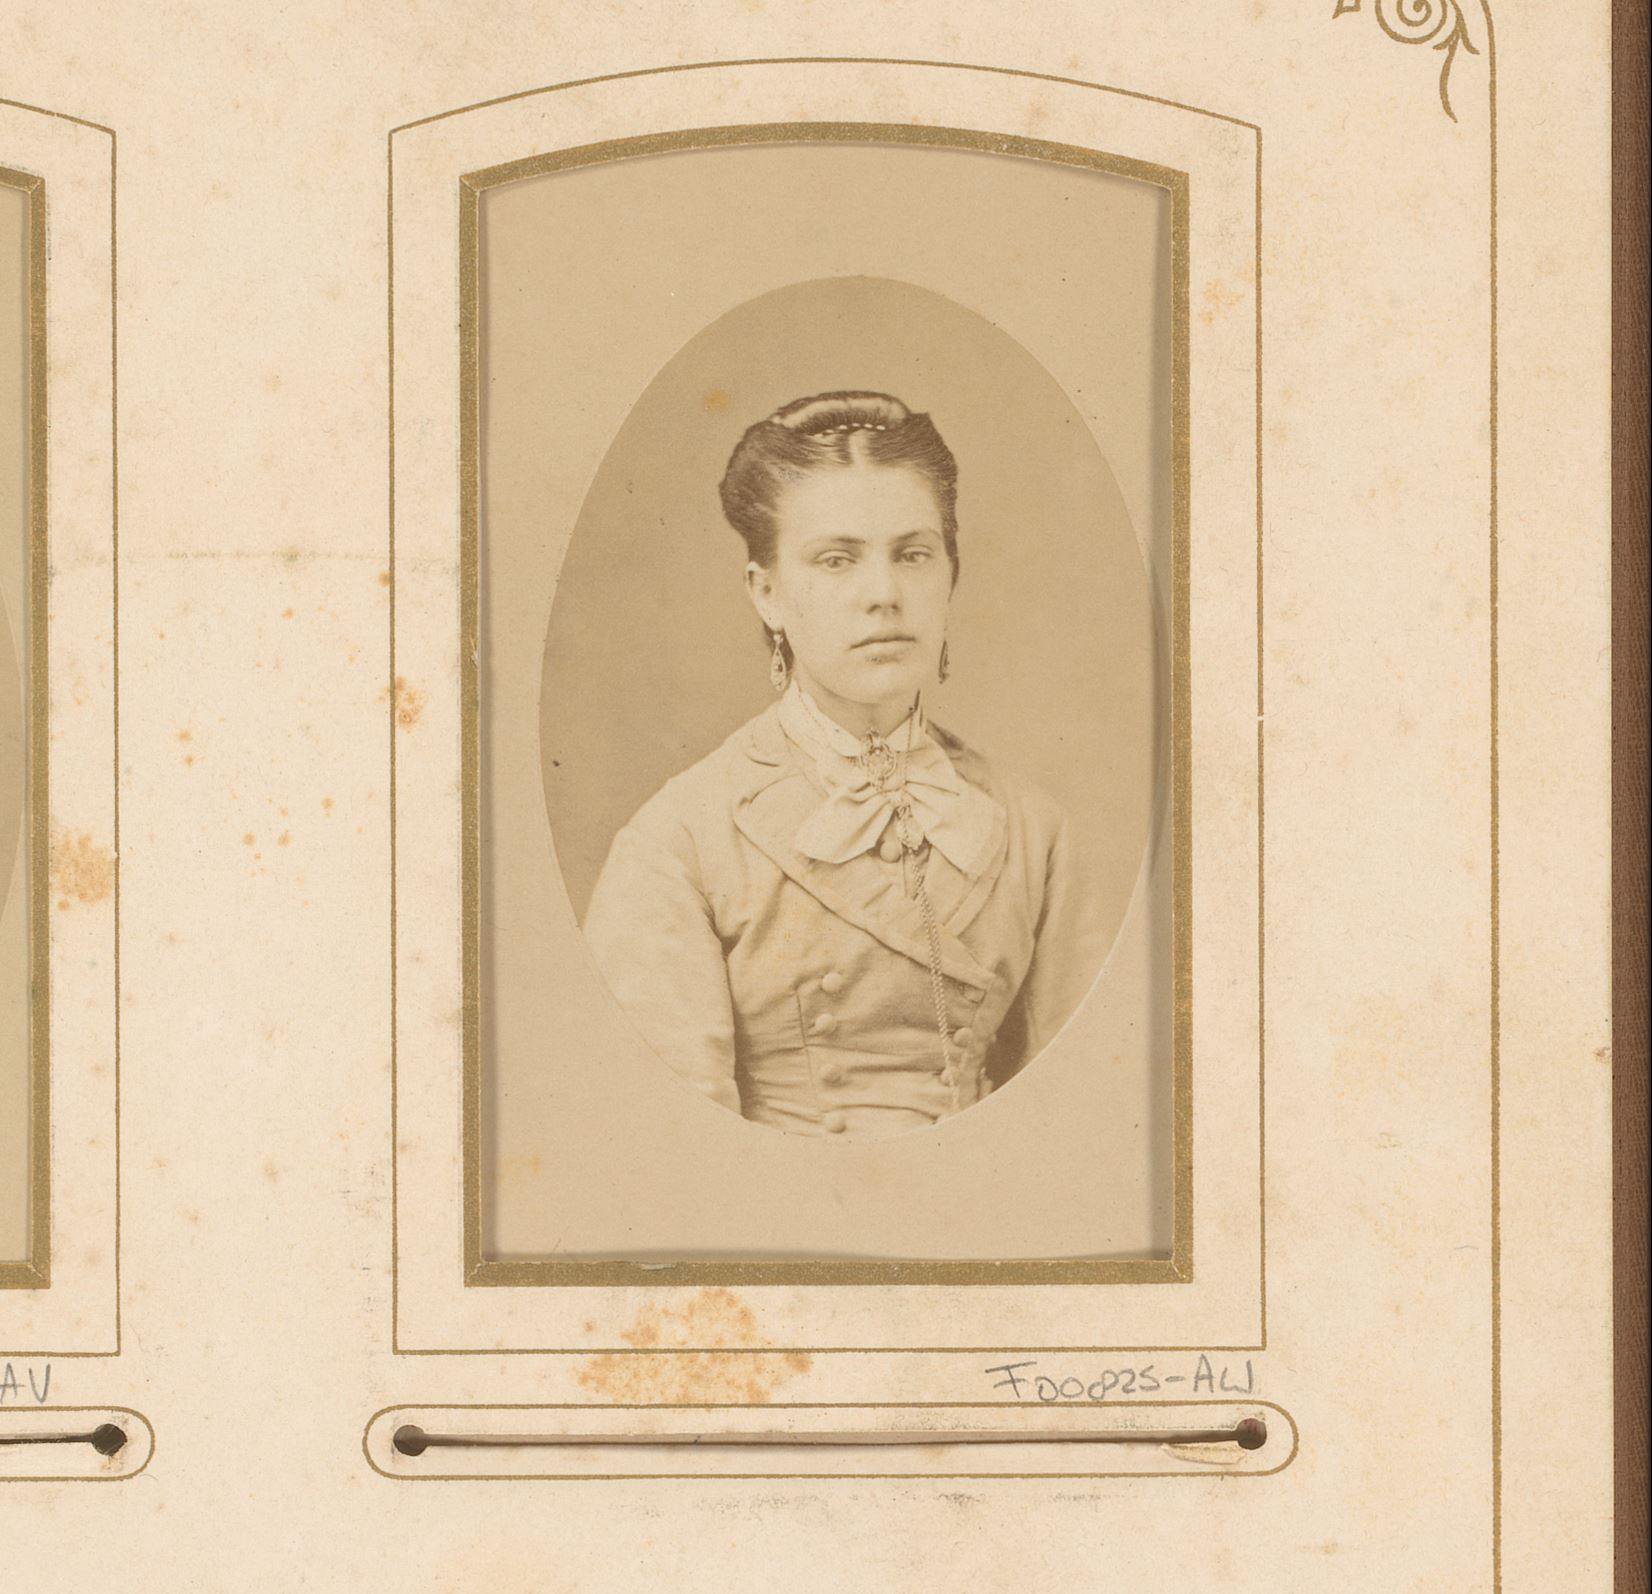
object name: photograph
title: Portret van een jonge vrouw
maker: jan george mulder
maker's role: fotograaf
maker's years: 1816-1895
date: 1865-1887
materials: cardboard, photographic support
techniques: albumen print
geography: haarlem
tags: adolescent, young woman, maiden, historical persons - bb - woman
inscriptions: annotation: ‘19 jaar’, inscription: ‘JGM/ PHOTOGR. ATELIER/ J. G. MULDER/ Lange Bagijnestraat/ over de Israëlitische Kerk./ HAARLEM/ De plaat blijft tot nabestelling bewaard.’